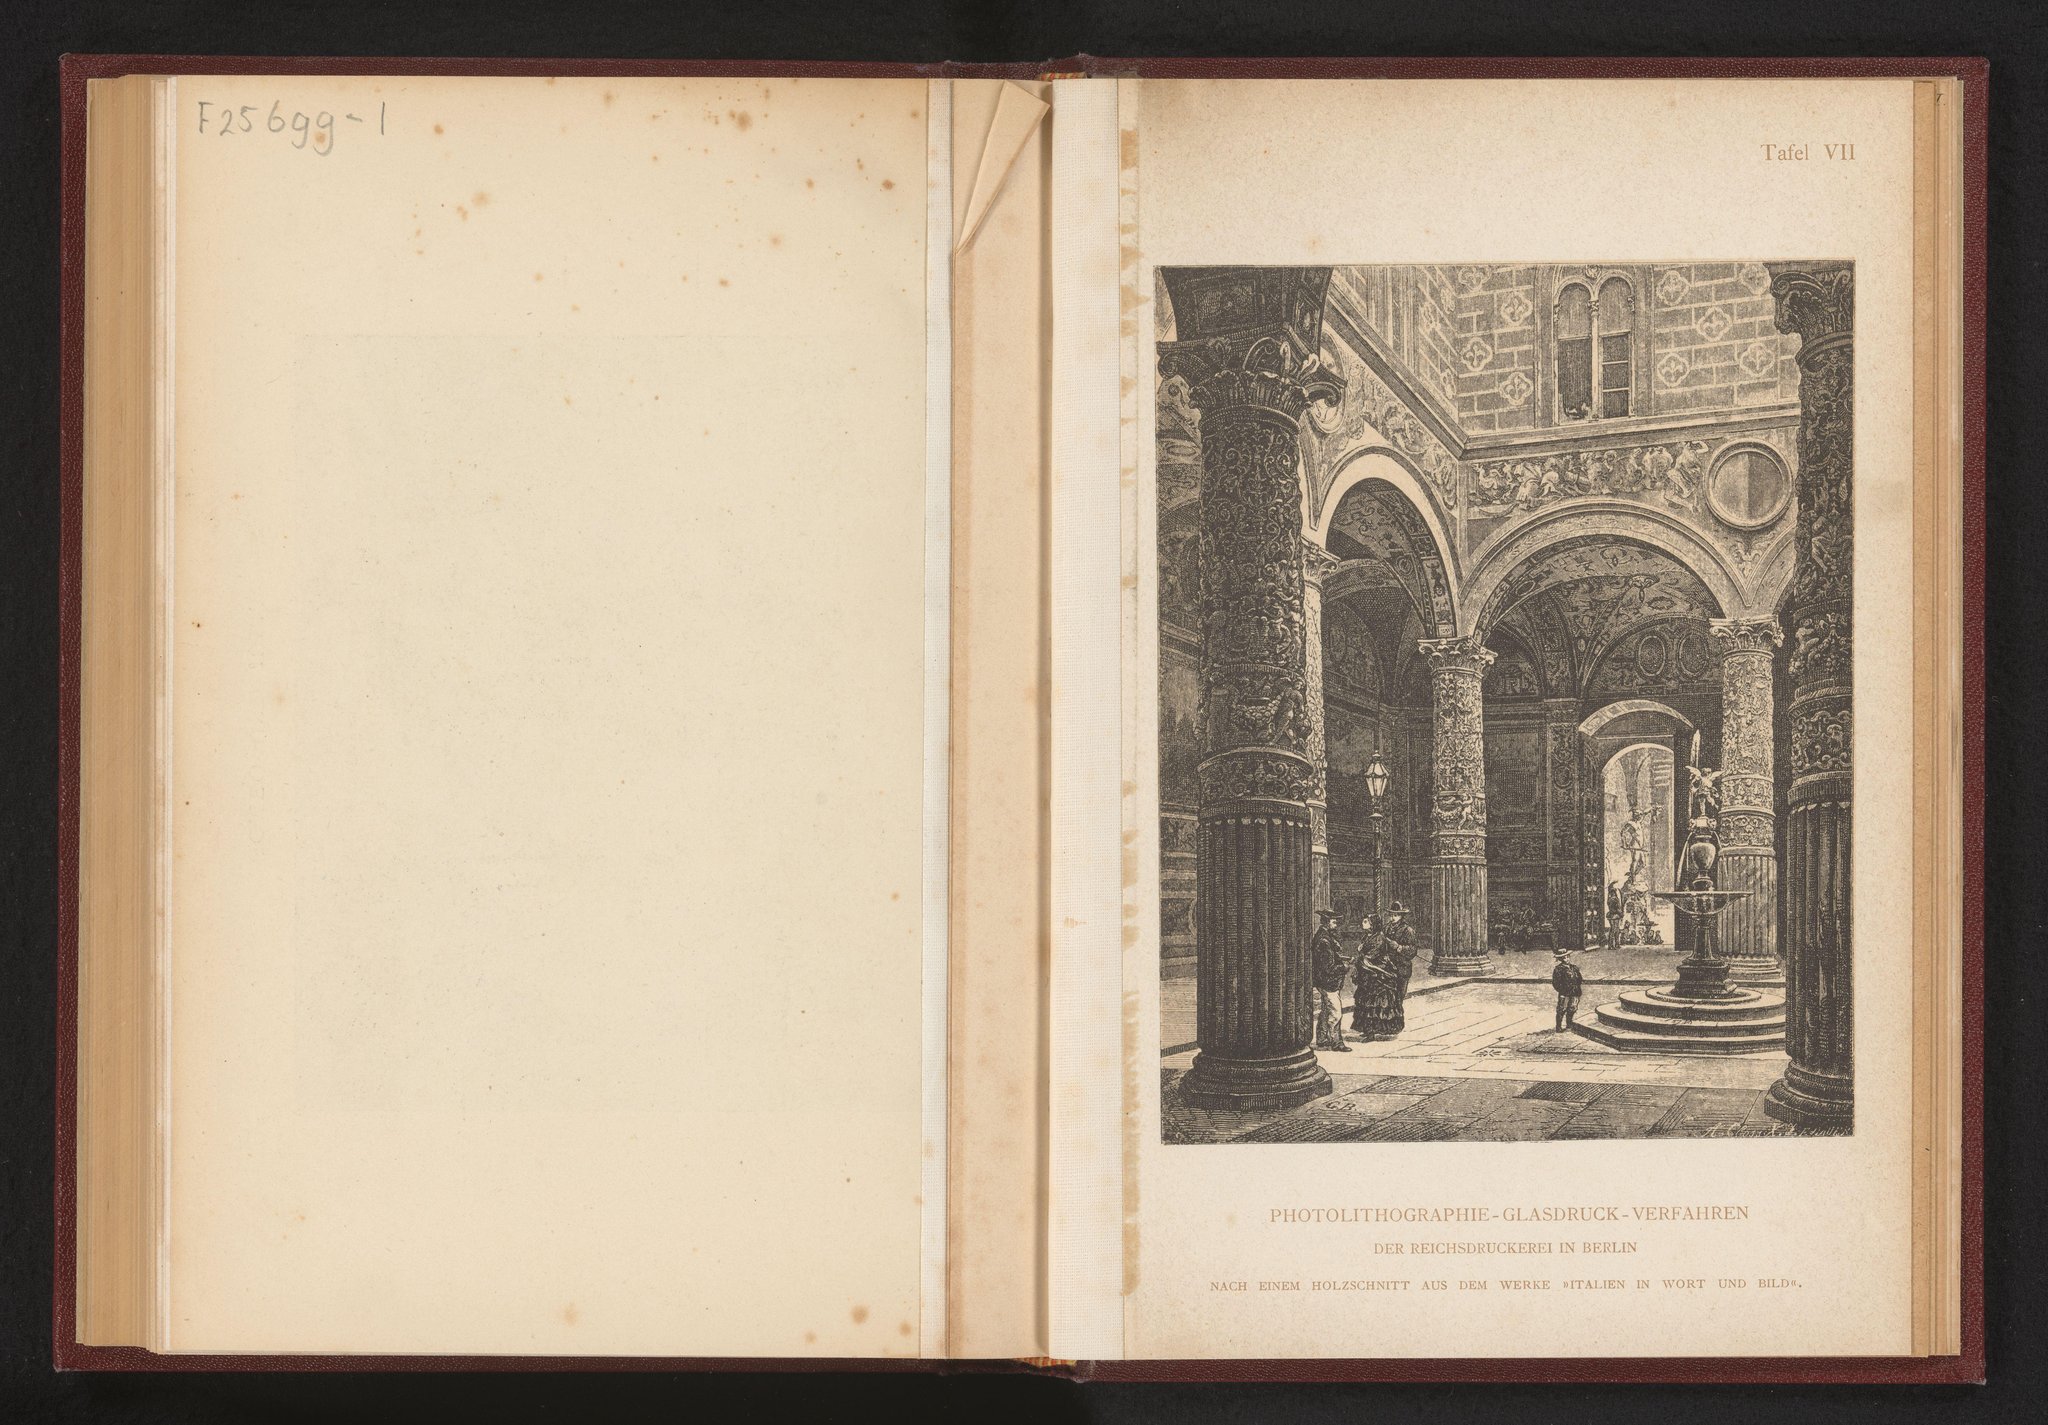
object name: page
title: Reproductie van een houtsnede van een binnenplaats met fontein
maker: Anonymous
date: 1885-1890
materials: paper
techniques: photolithography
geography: berlin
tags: courtyard, ornamental fountain, italy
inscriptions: number: ‘Tafel VII’, inscription: ‘PHOTOLITHOGRAPHIE-GLASDRUCK-VERFAHREN/ DER REICHSDRUCKEREI IN BERLIN/ NACH EINEM HOLZSCHNITT AUS DEM WERKE "ITALIEN IN WORT UND BILD".’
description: Prent op veertiende ongenummerde pagina na pagina 351.